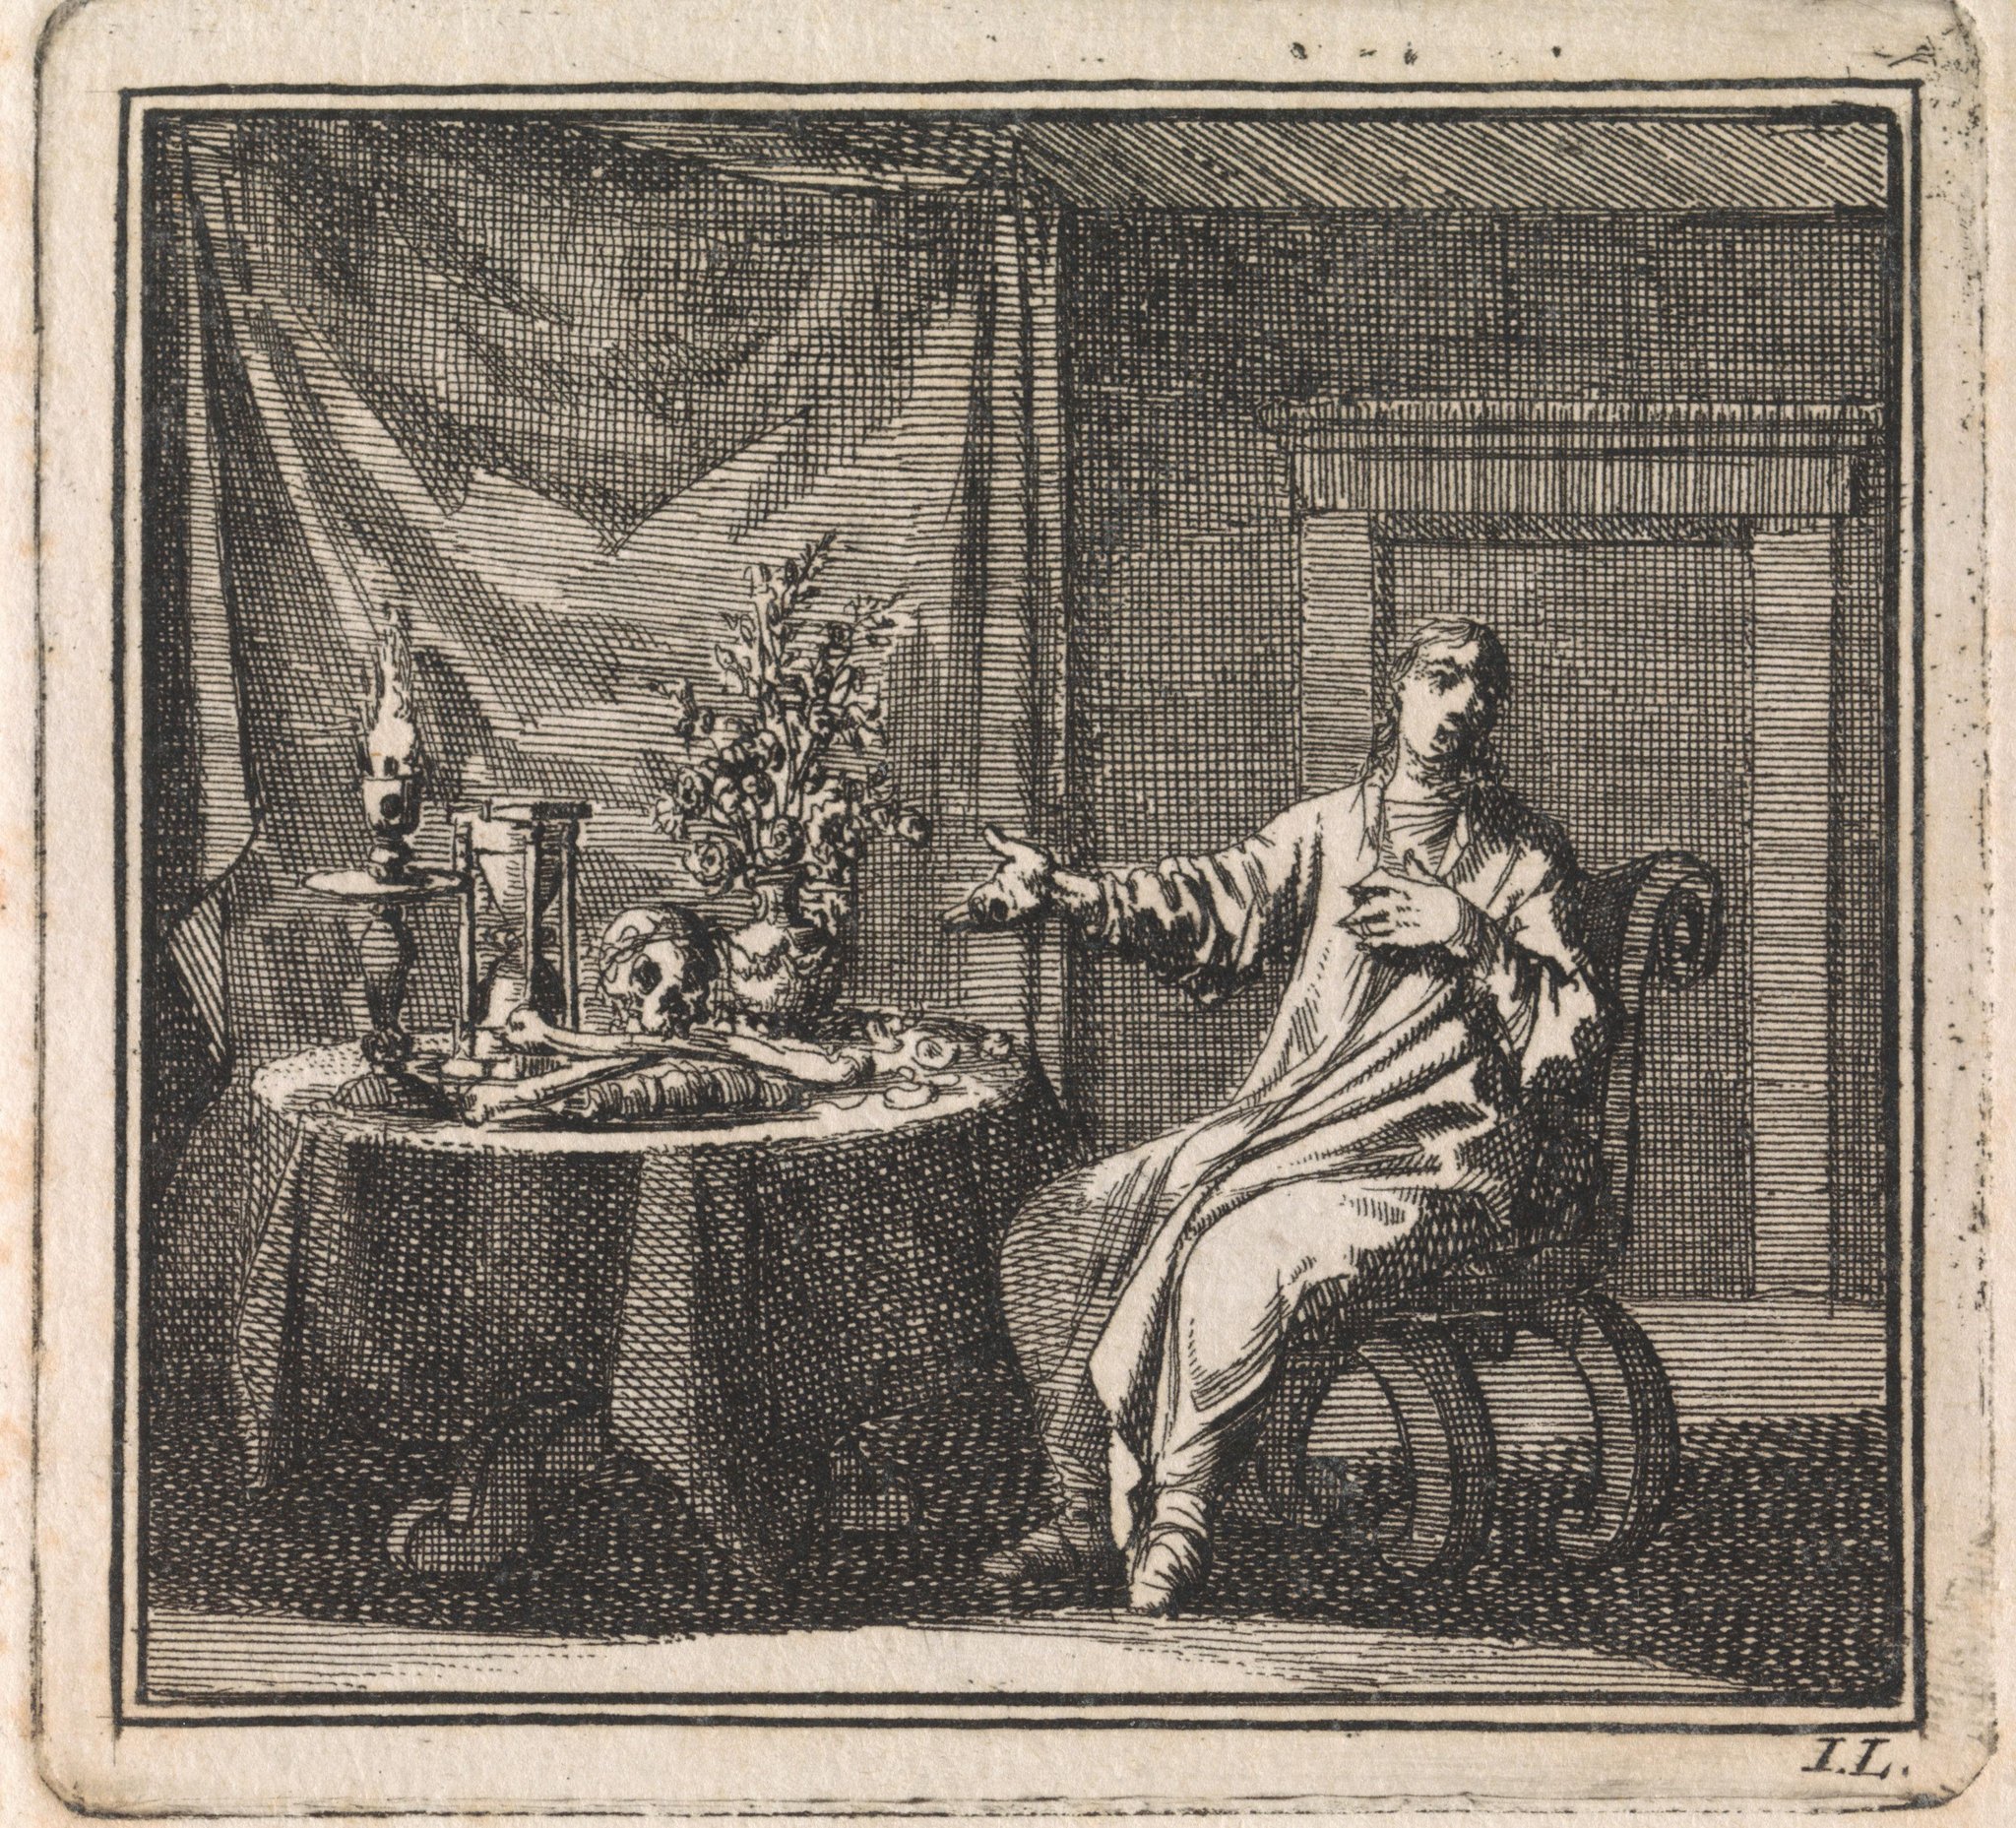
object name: book illustration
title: Vrouw wijst op de vanitassymbolen op de tafel voor haar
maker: jan luyken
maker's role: draughtsman, print maker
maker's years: 1649-1712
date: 1710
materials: paper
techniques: etching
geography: amsterdam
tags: 'vanitas' symbols, skull as symbol of 'vanitas', hourglass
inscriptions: collector's mark: Lugt 2228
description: Illustratie uit: Luyken, Jan. De onwaardige wereld, vertoond in vyftig zinnebeelden, met godlyke spreuken en stichtelyke verzen. Amsterdam: Pieter Arentsz. II (wed.) en Cornelis van der Sys, 1710, p. 58.